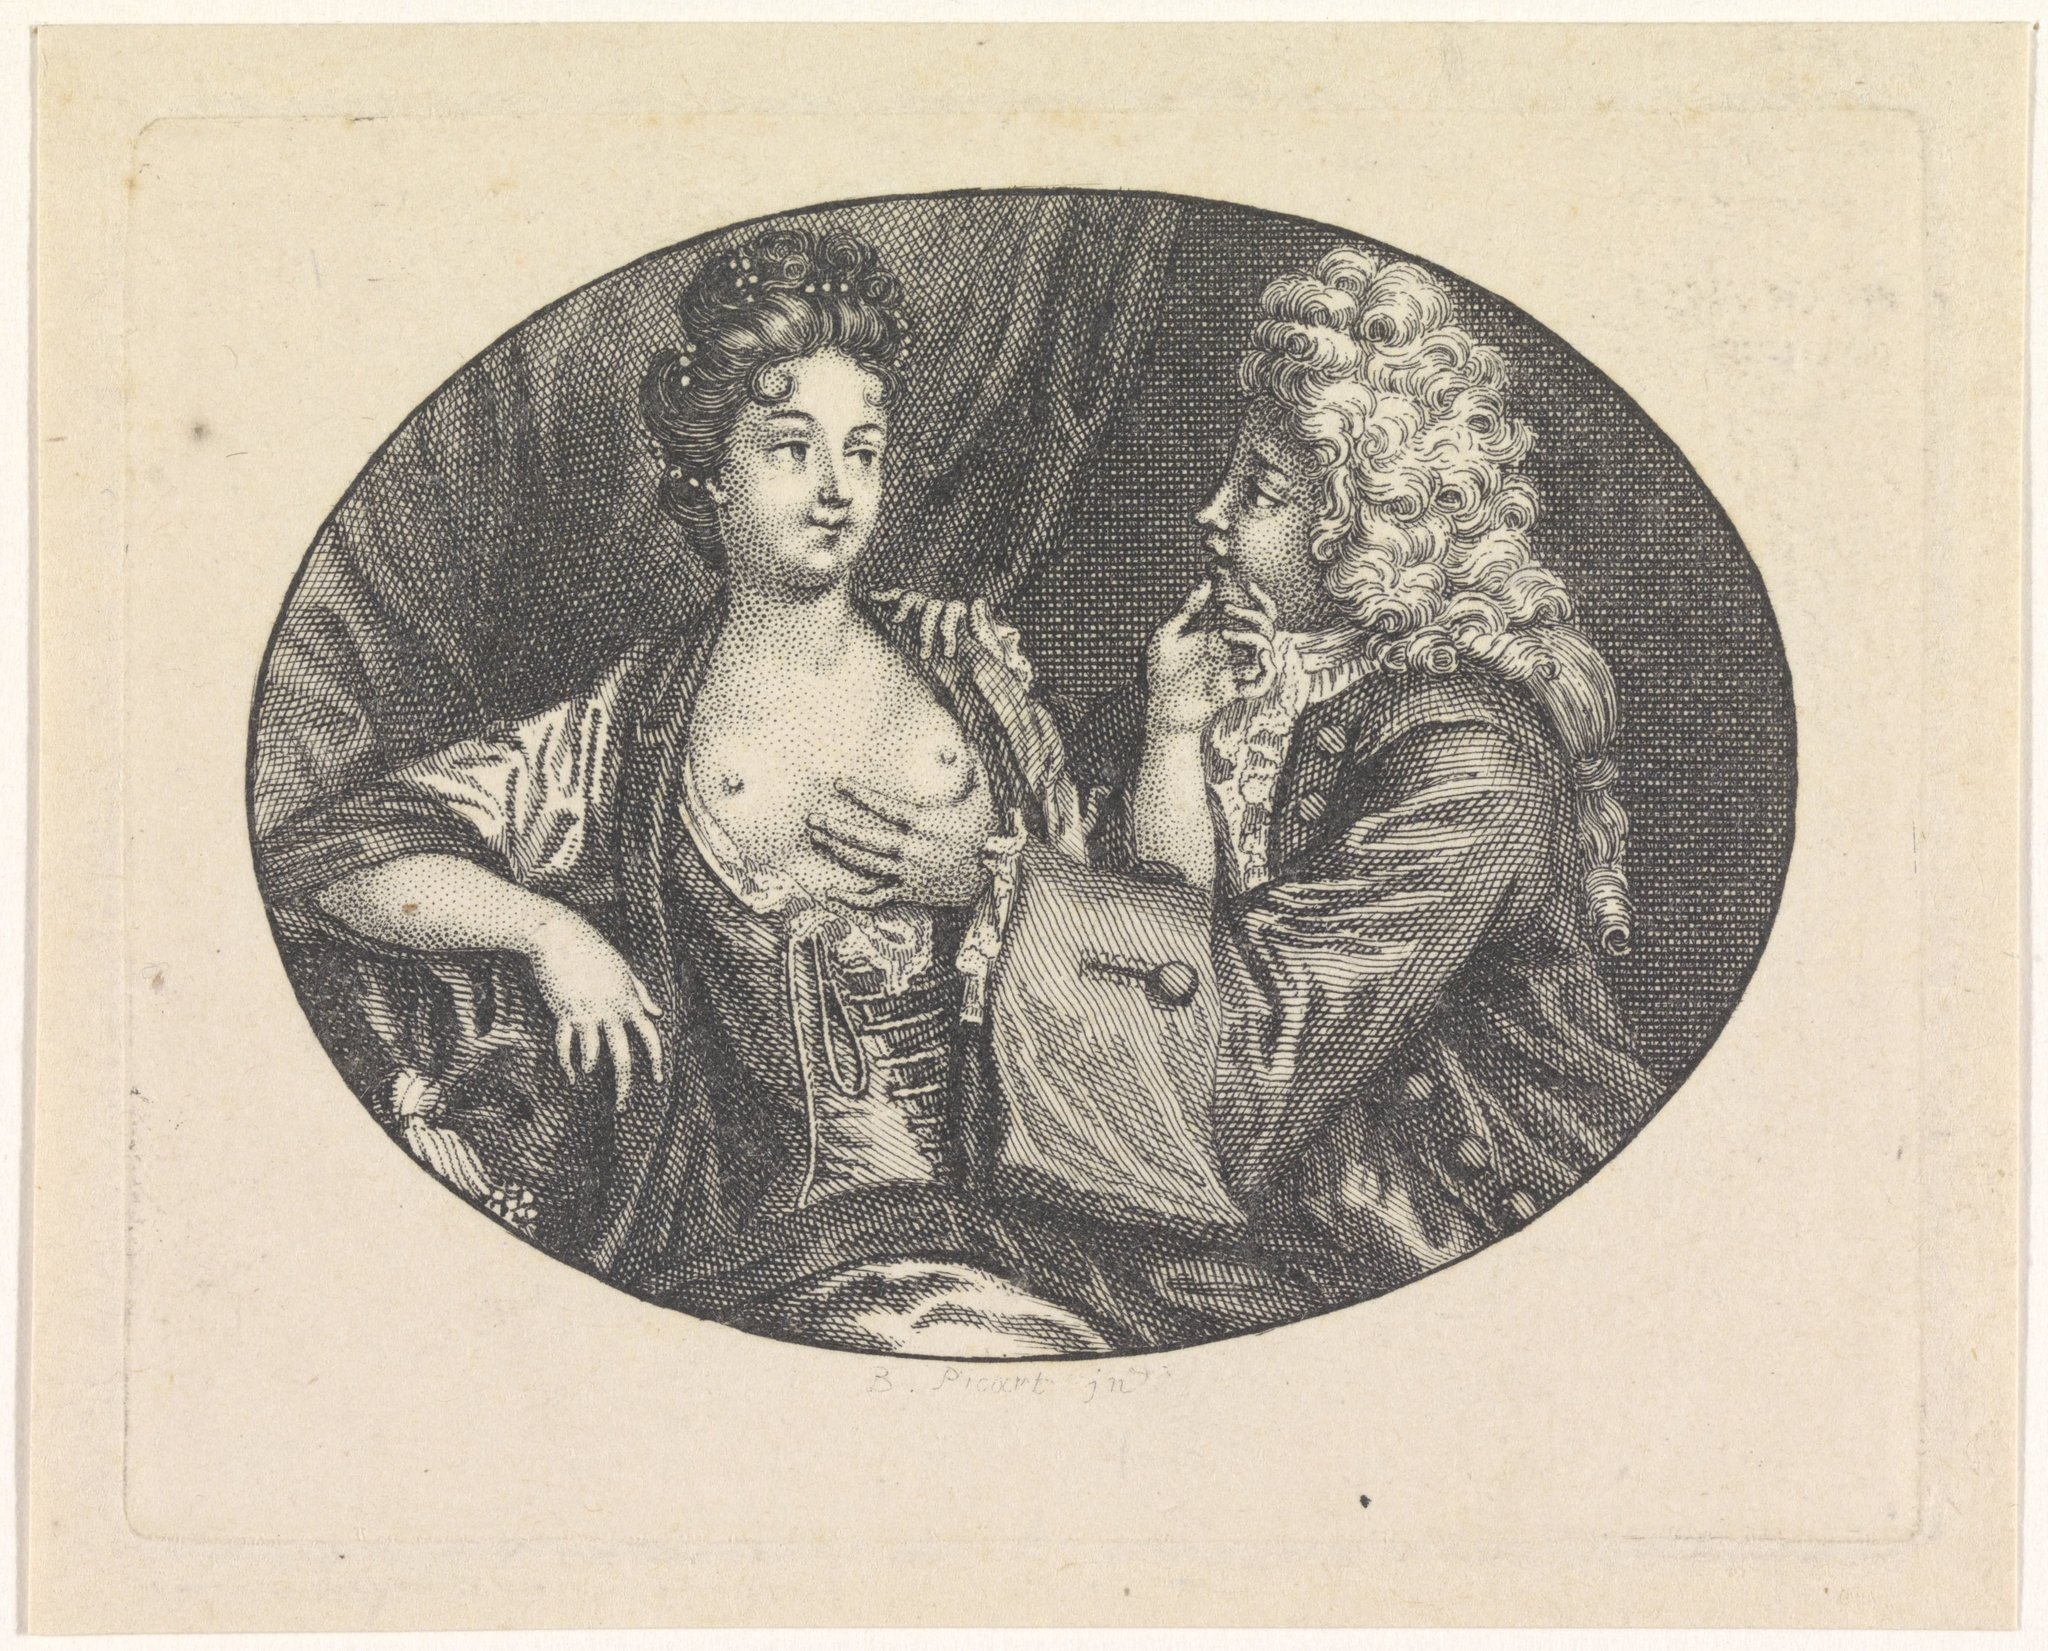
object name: print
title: Man betast een vrouw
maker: bernard picart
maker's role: draughtsman, print maker, publisher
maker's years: 1673-1733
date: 1683-1733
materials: paper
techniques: engraving, etching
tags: whore, prostitute, lovers; courting, flirting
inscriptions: collector's mark: Lugt 2228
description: Een man betast de borst van een vrouw. Zij draagt een jurk die haar borsten onbedekt laat en kietelt zijn kin.